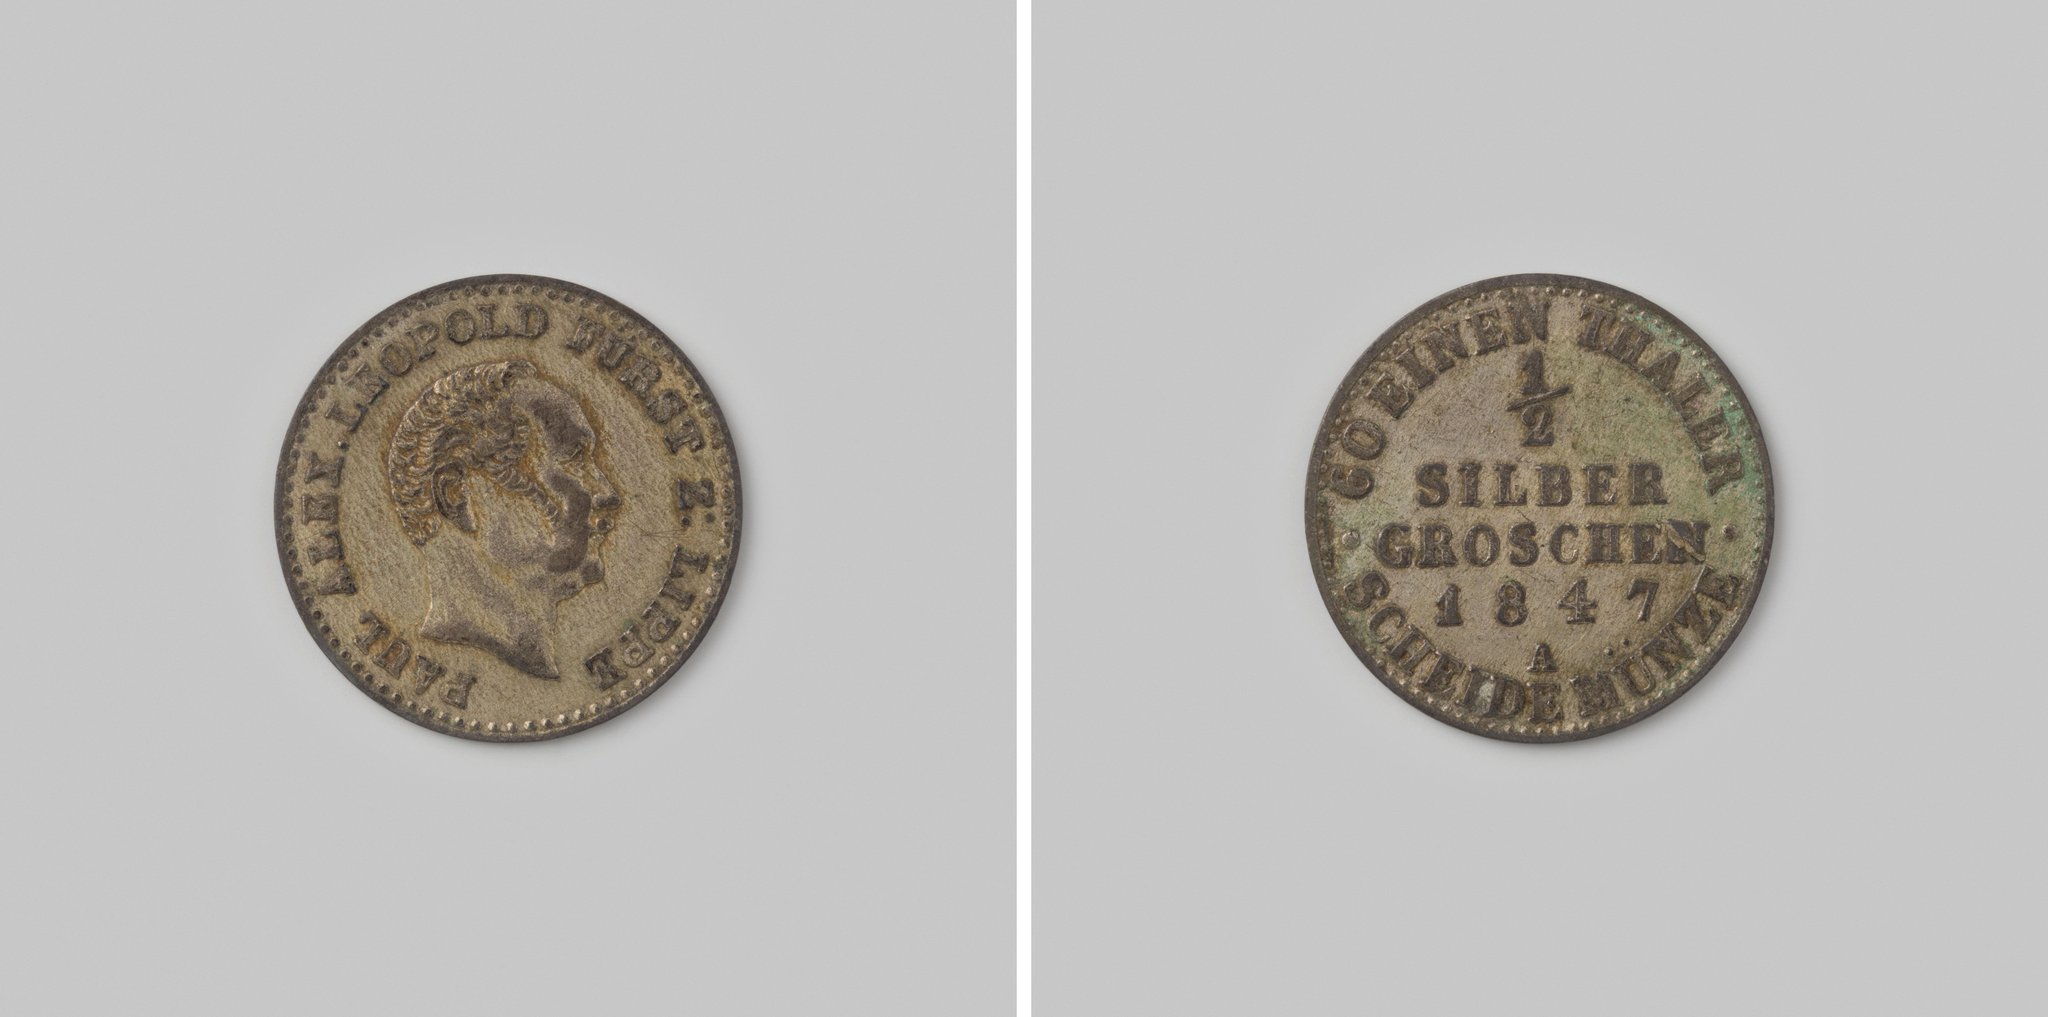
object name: coin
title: Pruisen, Friedrich Wilhelm III, ½ Silbergroschen,1847 A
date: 1847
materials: silver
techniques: striking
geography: berlin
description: Zilveren munt. Voorzijde: hoofd van de koning naar rechts. Keerzijde: waarde-aanduiding in drie regels, waaronder jaartal. Daaronder letter A. Gladde rand.